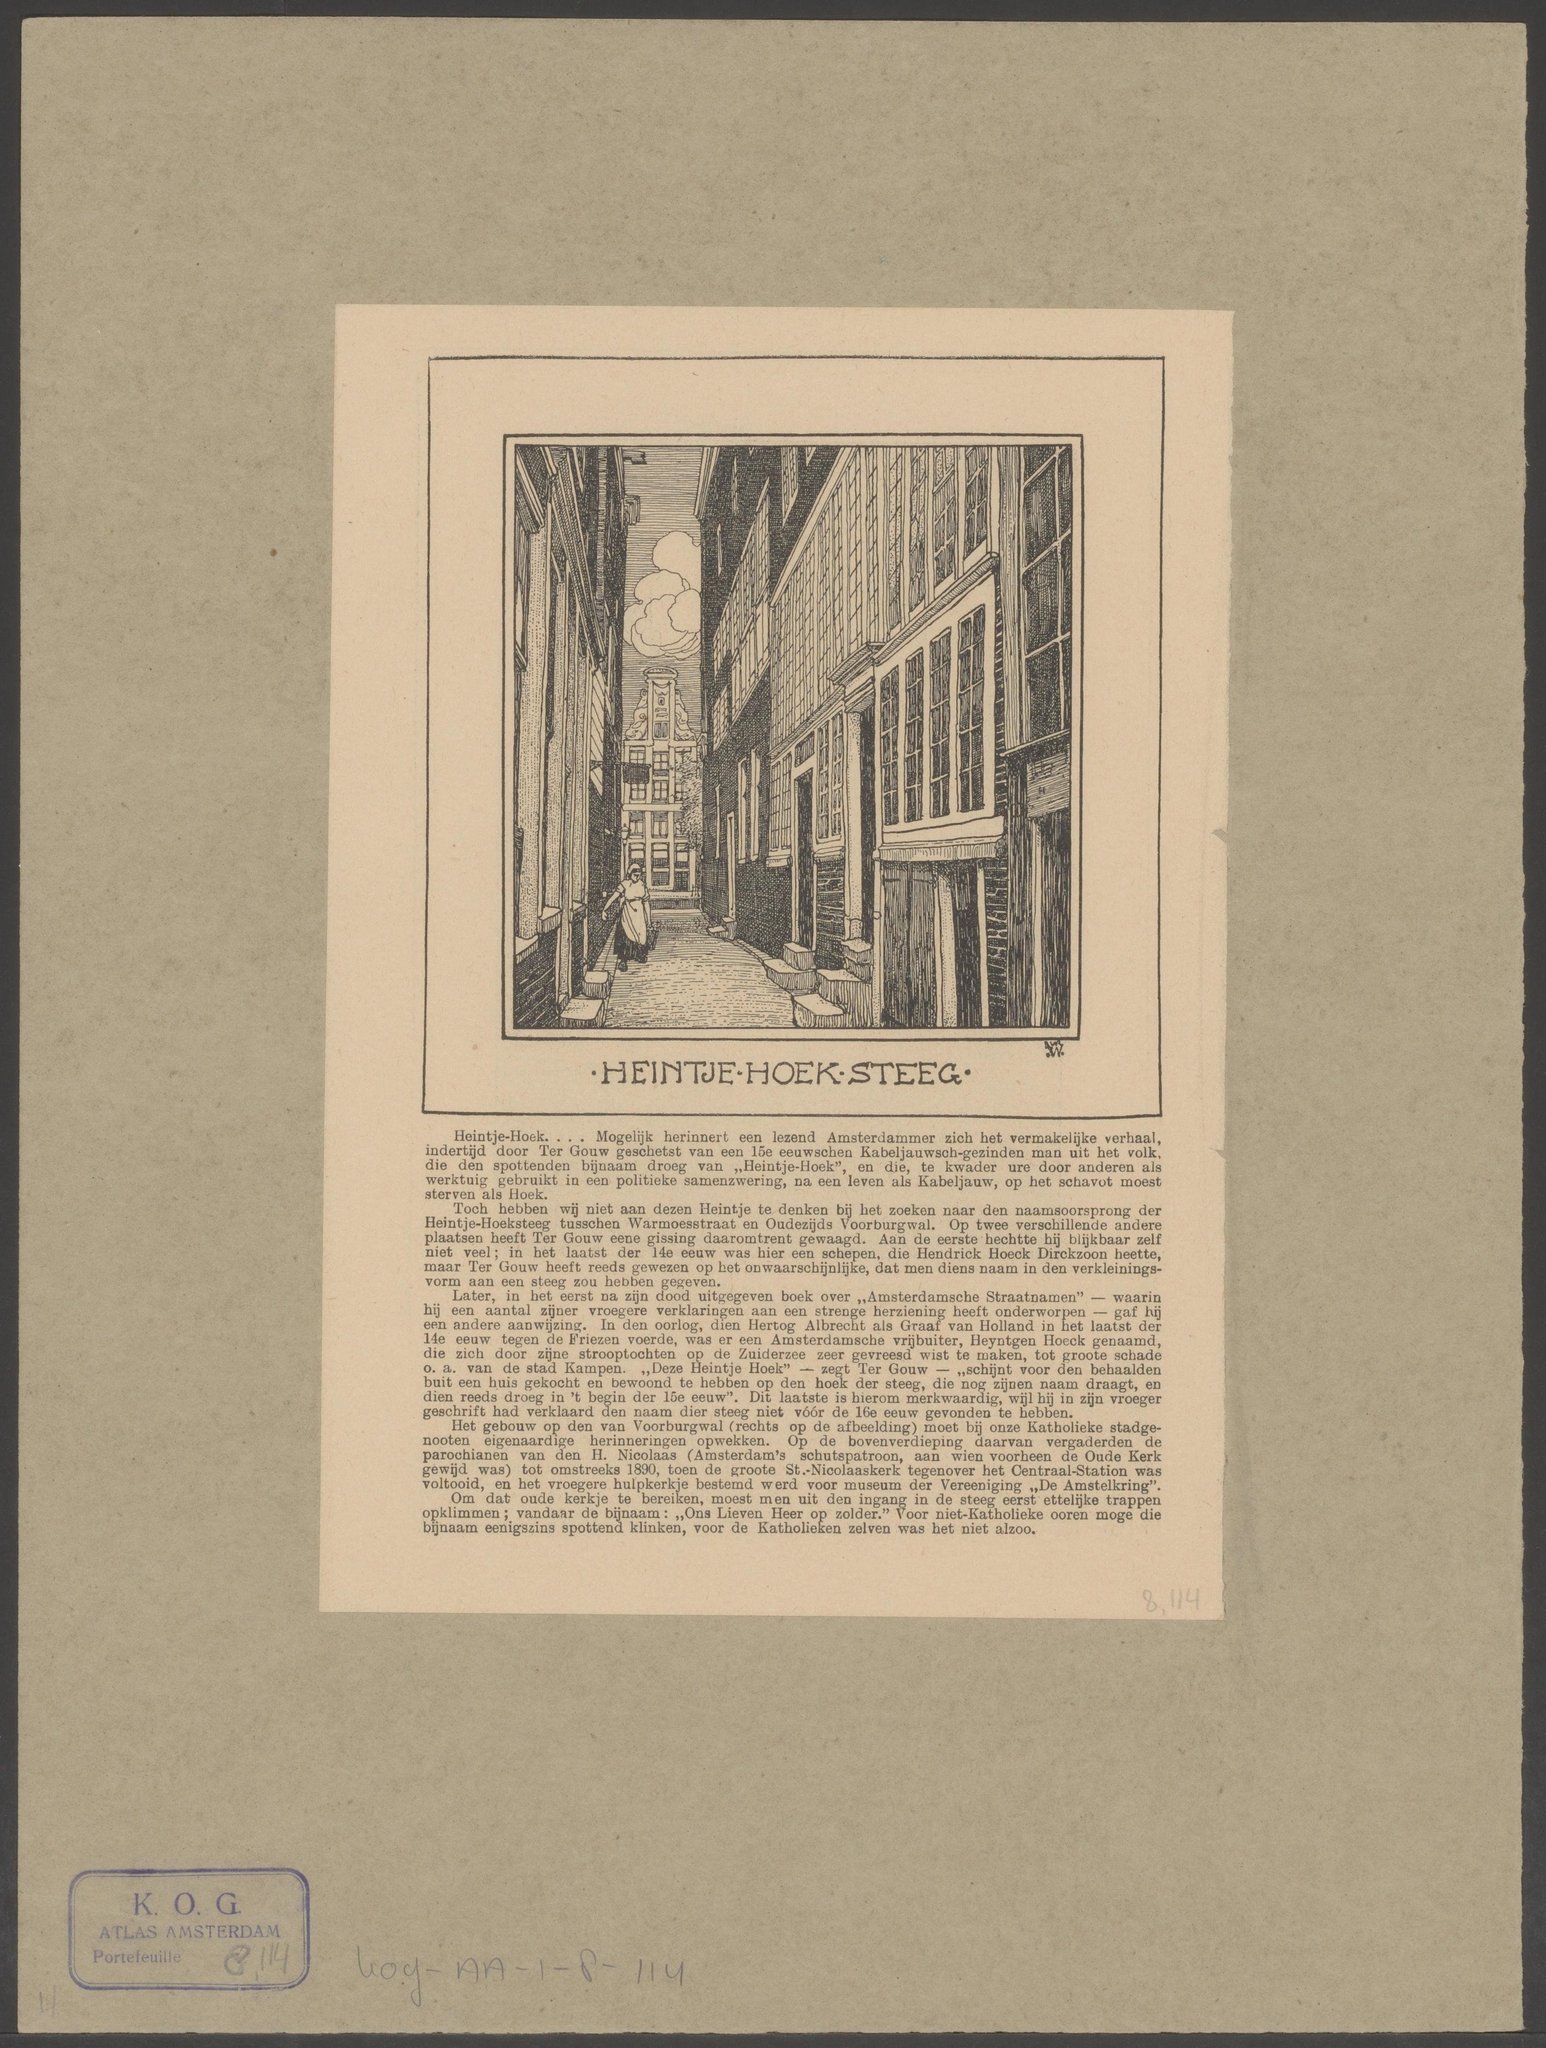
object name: photomechanical print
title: Oud-Amsterdam 100 Stadsgezichten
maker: willem wenckebach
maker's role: designer, draughtsman, painter, print maker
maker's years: 1860-1937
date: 1870-1923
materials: paper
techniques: letterpress printing, line block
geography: amsterdam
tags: city-view in general; 'veduta', lane, alley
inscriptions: collector's mark: ‘8,114’ Lugt 1641b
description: Onderwerpsrubriek binnen de Atlas Amsterdam: Heerengracht (Nieuwe), Heiligeweg, Heisteeg, Heintjehoeksteeg, Hekelveld, Hemelrijk, Hoedemakerspad, Hol (‘t), Houtgracht, Houtewaelerboom, Houtkoopersdwarsstraat, Houttuinen (Joden), Houttuinen (Haarlemmer), Hugo de Grootkade, Huidenstraat, Huidenvetterstraat, Huydecoperstraat.